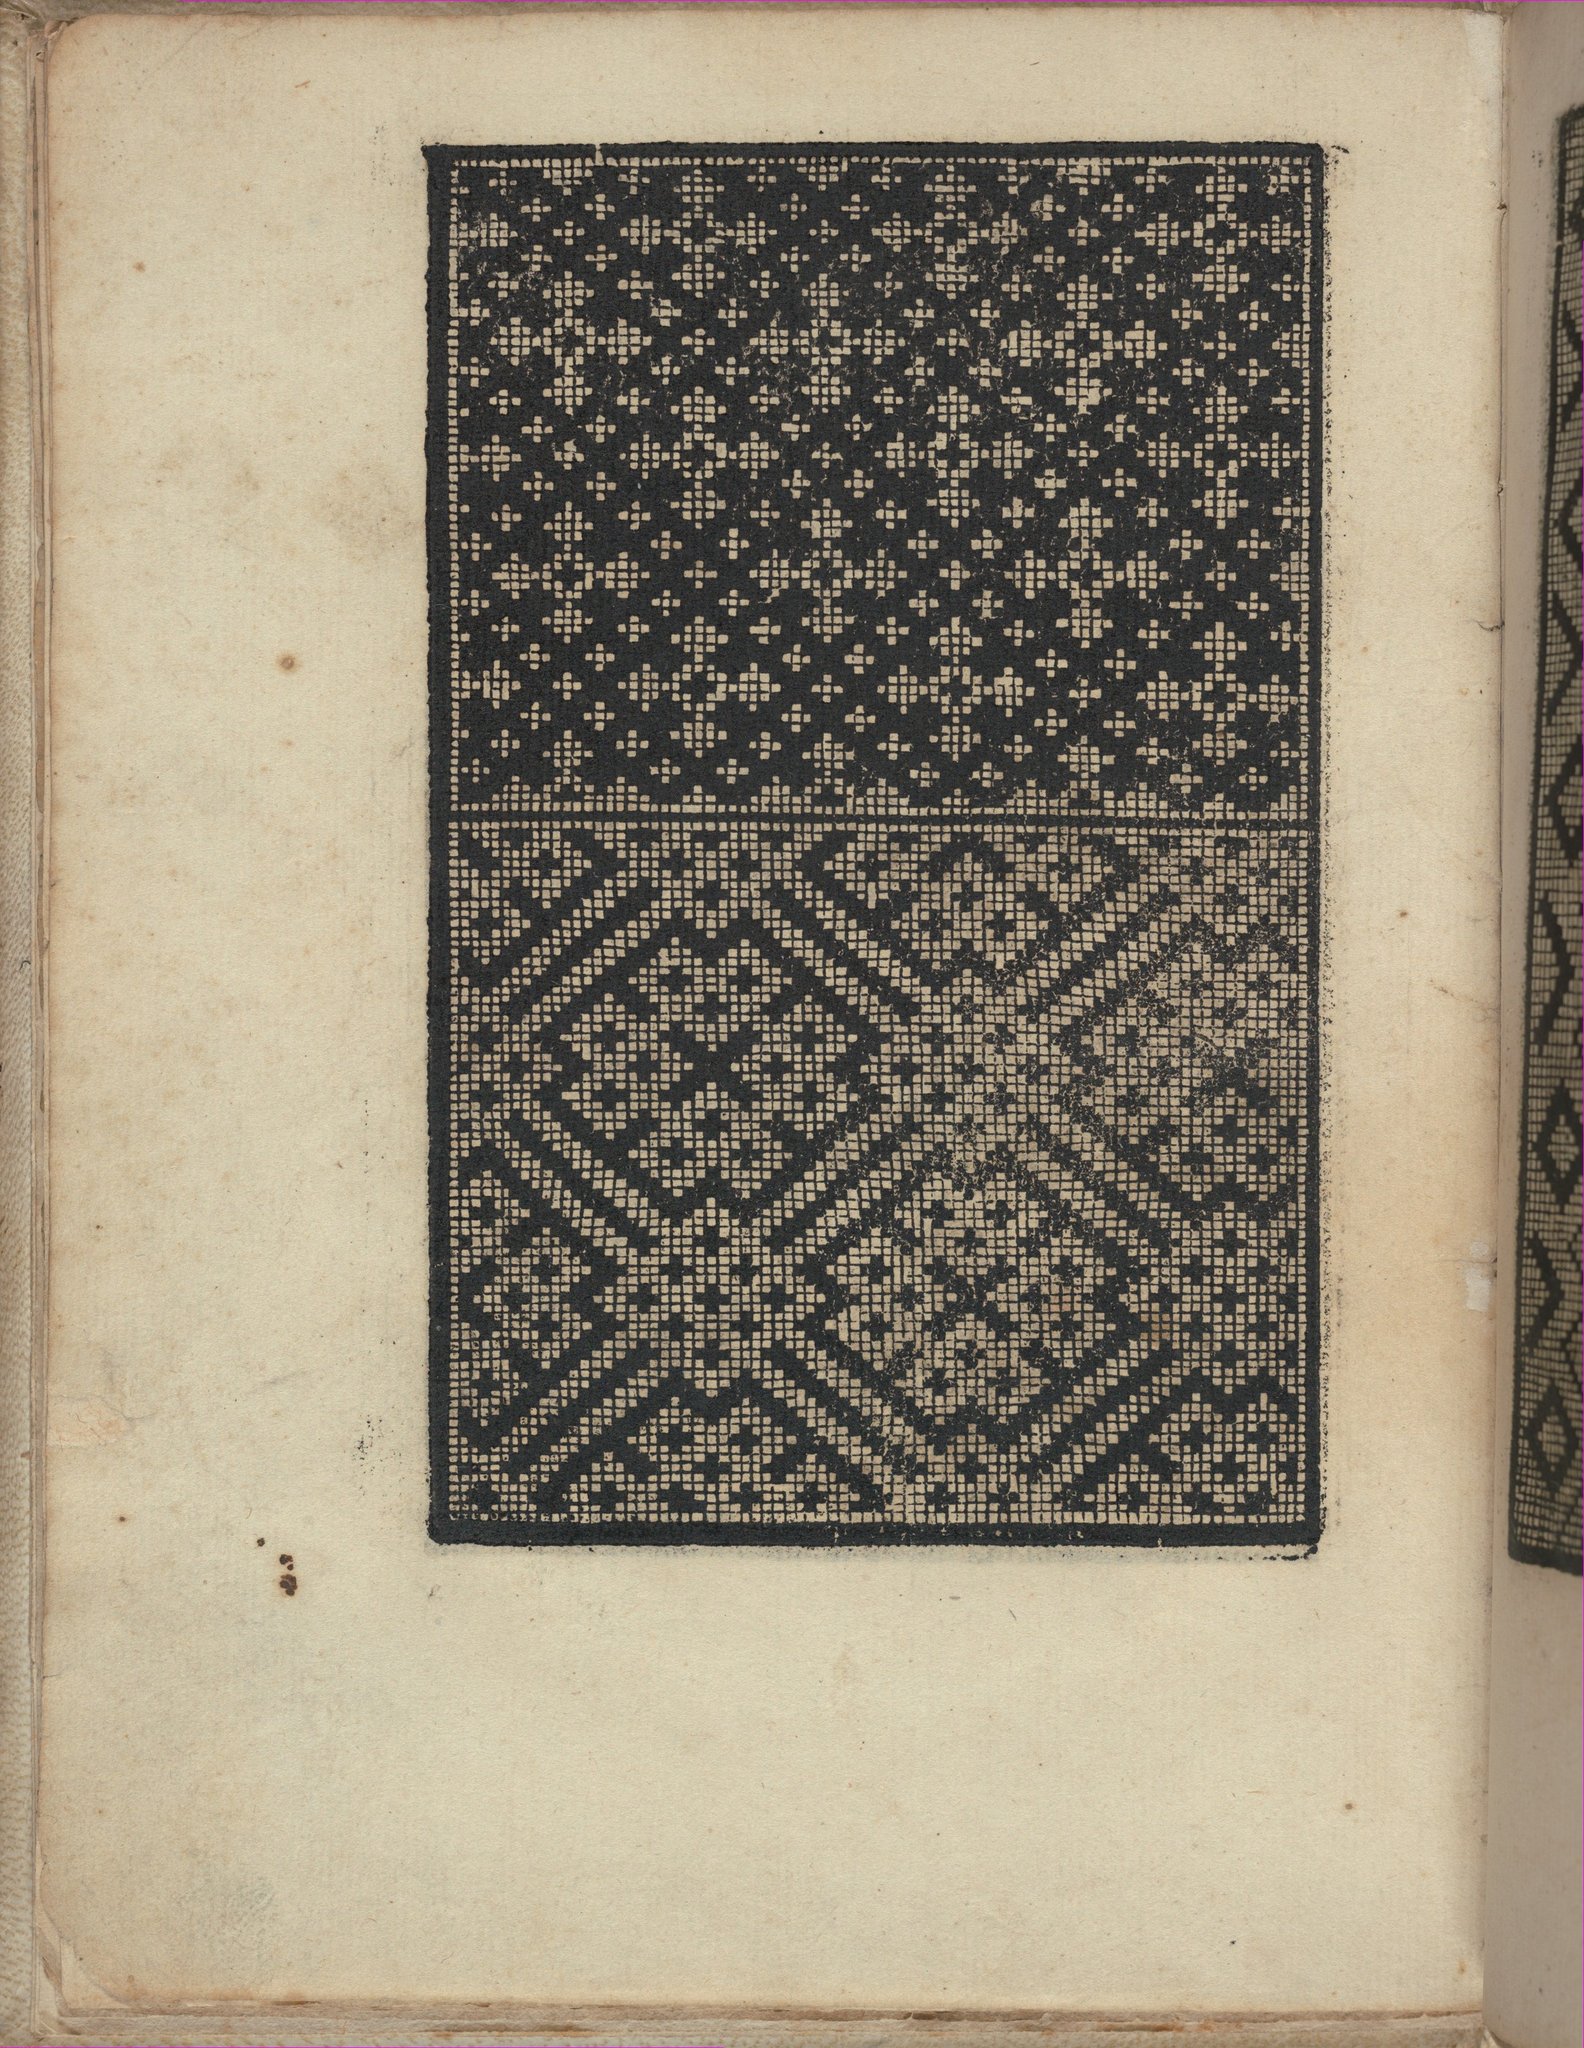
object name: book print ornament architecture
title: Esemplario di Lauori..., page 10 (recto)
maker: giovanni andrea vavassore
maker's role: publisher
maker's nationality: italian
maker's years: 1530-1573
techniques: woodcut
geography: venice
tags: ornament